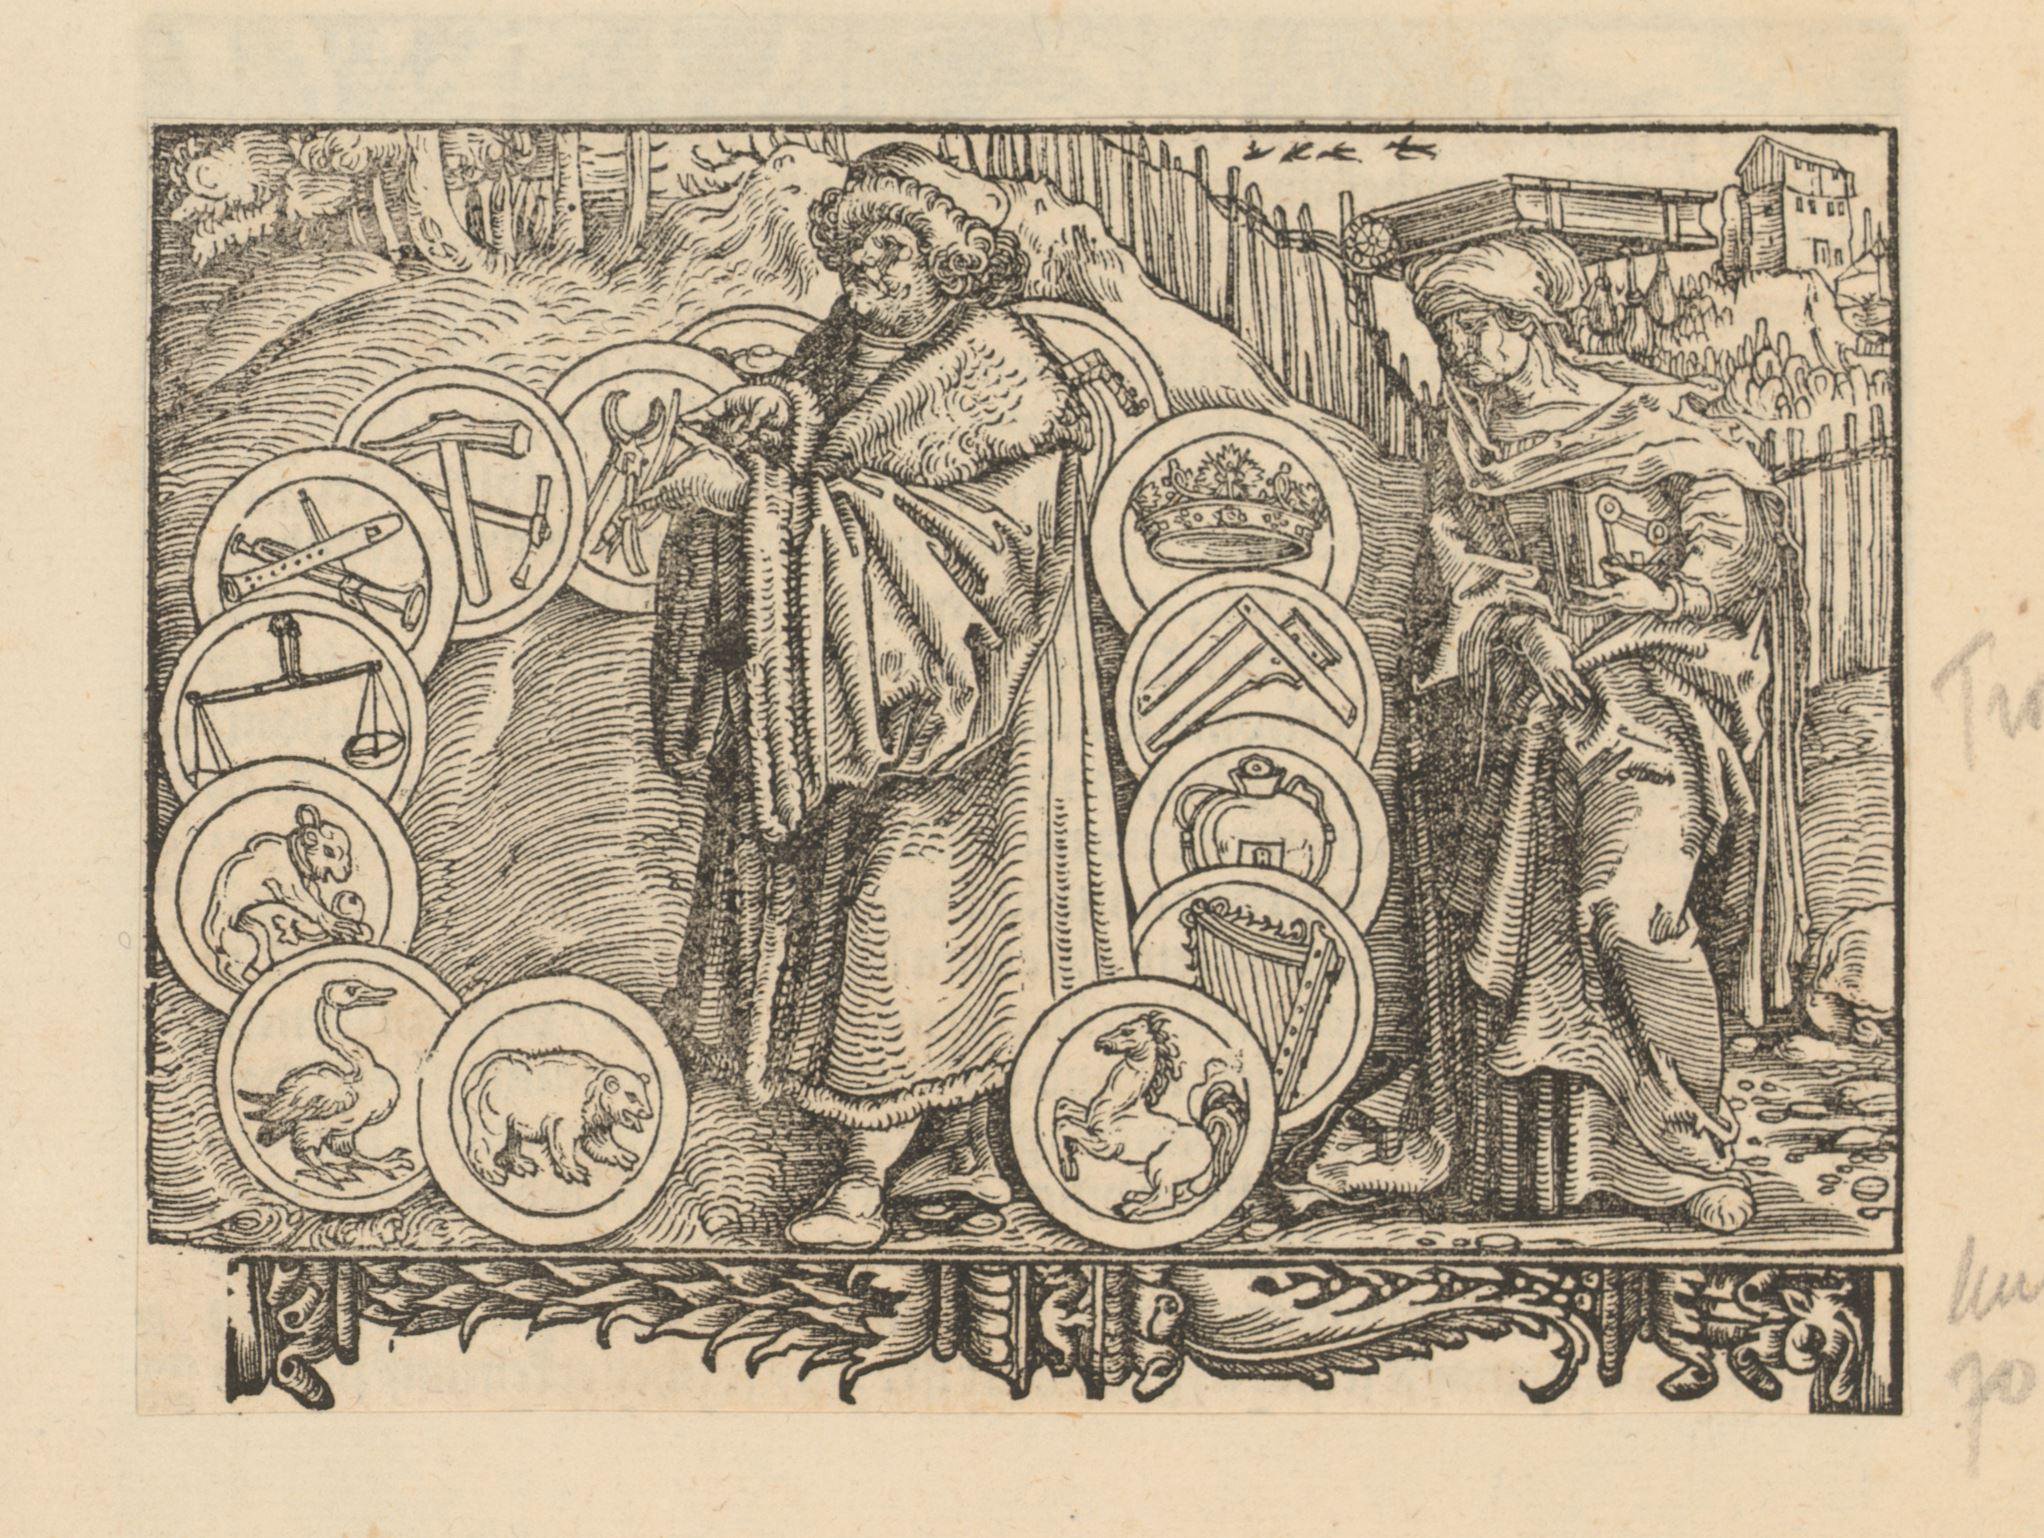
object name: book illustration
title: Geleerde omringd door emblemen met heraldiek en de personificatie van Wijsheid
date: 1514-1532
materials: paper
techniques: letterpress printing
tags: wisdom; 'sapienza', 'sapienza humana', 'sapienza vera' (ripa), the books of wisdom, abstract ideas and concepts (+ abstract concept represented by female figure), armorial bearing, heraldry, 'litterae', symbolic representations, allegories and emblems ~ literature; 'lettere' (ripa)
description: Deze prent is gebruikt in: Petrarca, Francesco. Von der Artzney bayder Glück, des guten und widerwertigen: unnd weß sich ain yeder inn Gelück und Unglück halten sol (...). Augsburg: Heinrich Steiner, 1532. Deze uitgave is ook bekend onder de titel 'Trostspiegel in Glück und Unglück'. Deze prent is ook gebruikt in: Cicero, Marcus Tulius. Officia M.T.C. Ein Buch so Marcus Tullius Cicero der Römer zu seynem (...). [Vertaald uit het Latijn door] Johann von Schwarzenberg. Augsburg: Heinrich Steiner, 1531. Deze prent is ook gebruikt op de titelpagina van: Urban, Vergilius Polydorus von. Von den Erfindern der ding (...). [Vertaald uit het Latijn door] Marcus Tatius Alpinus. Augsburg: Heinrich Steiner, 1537.